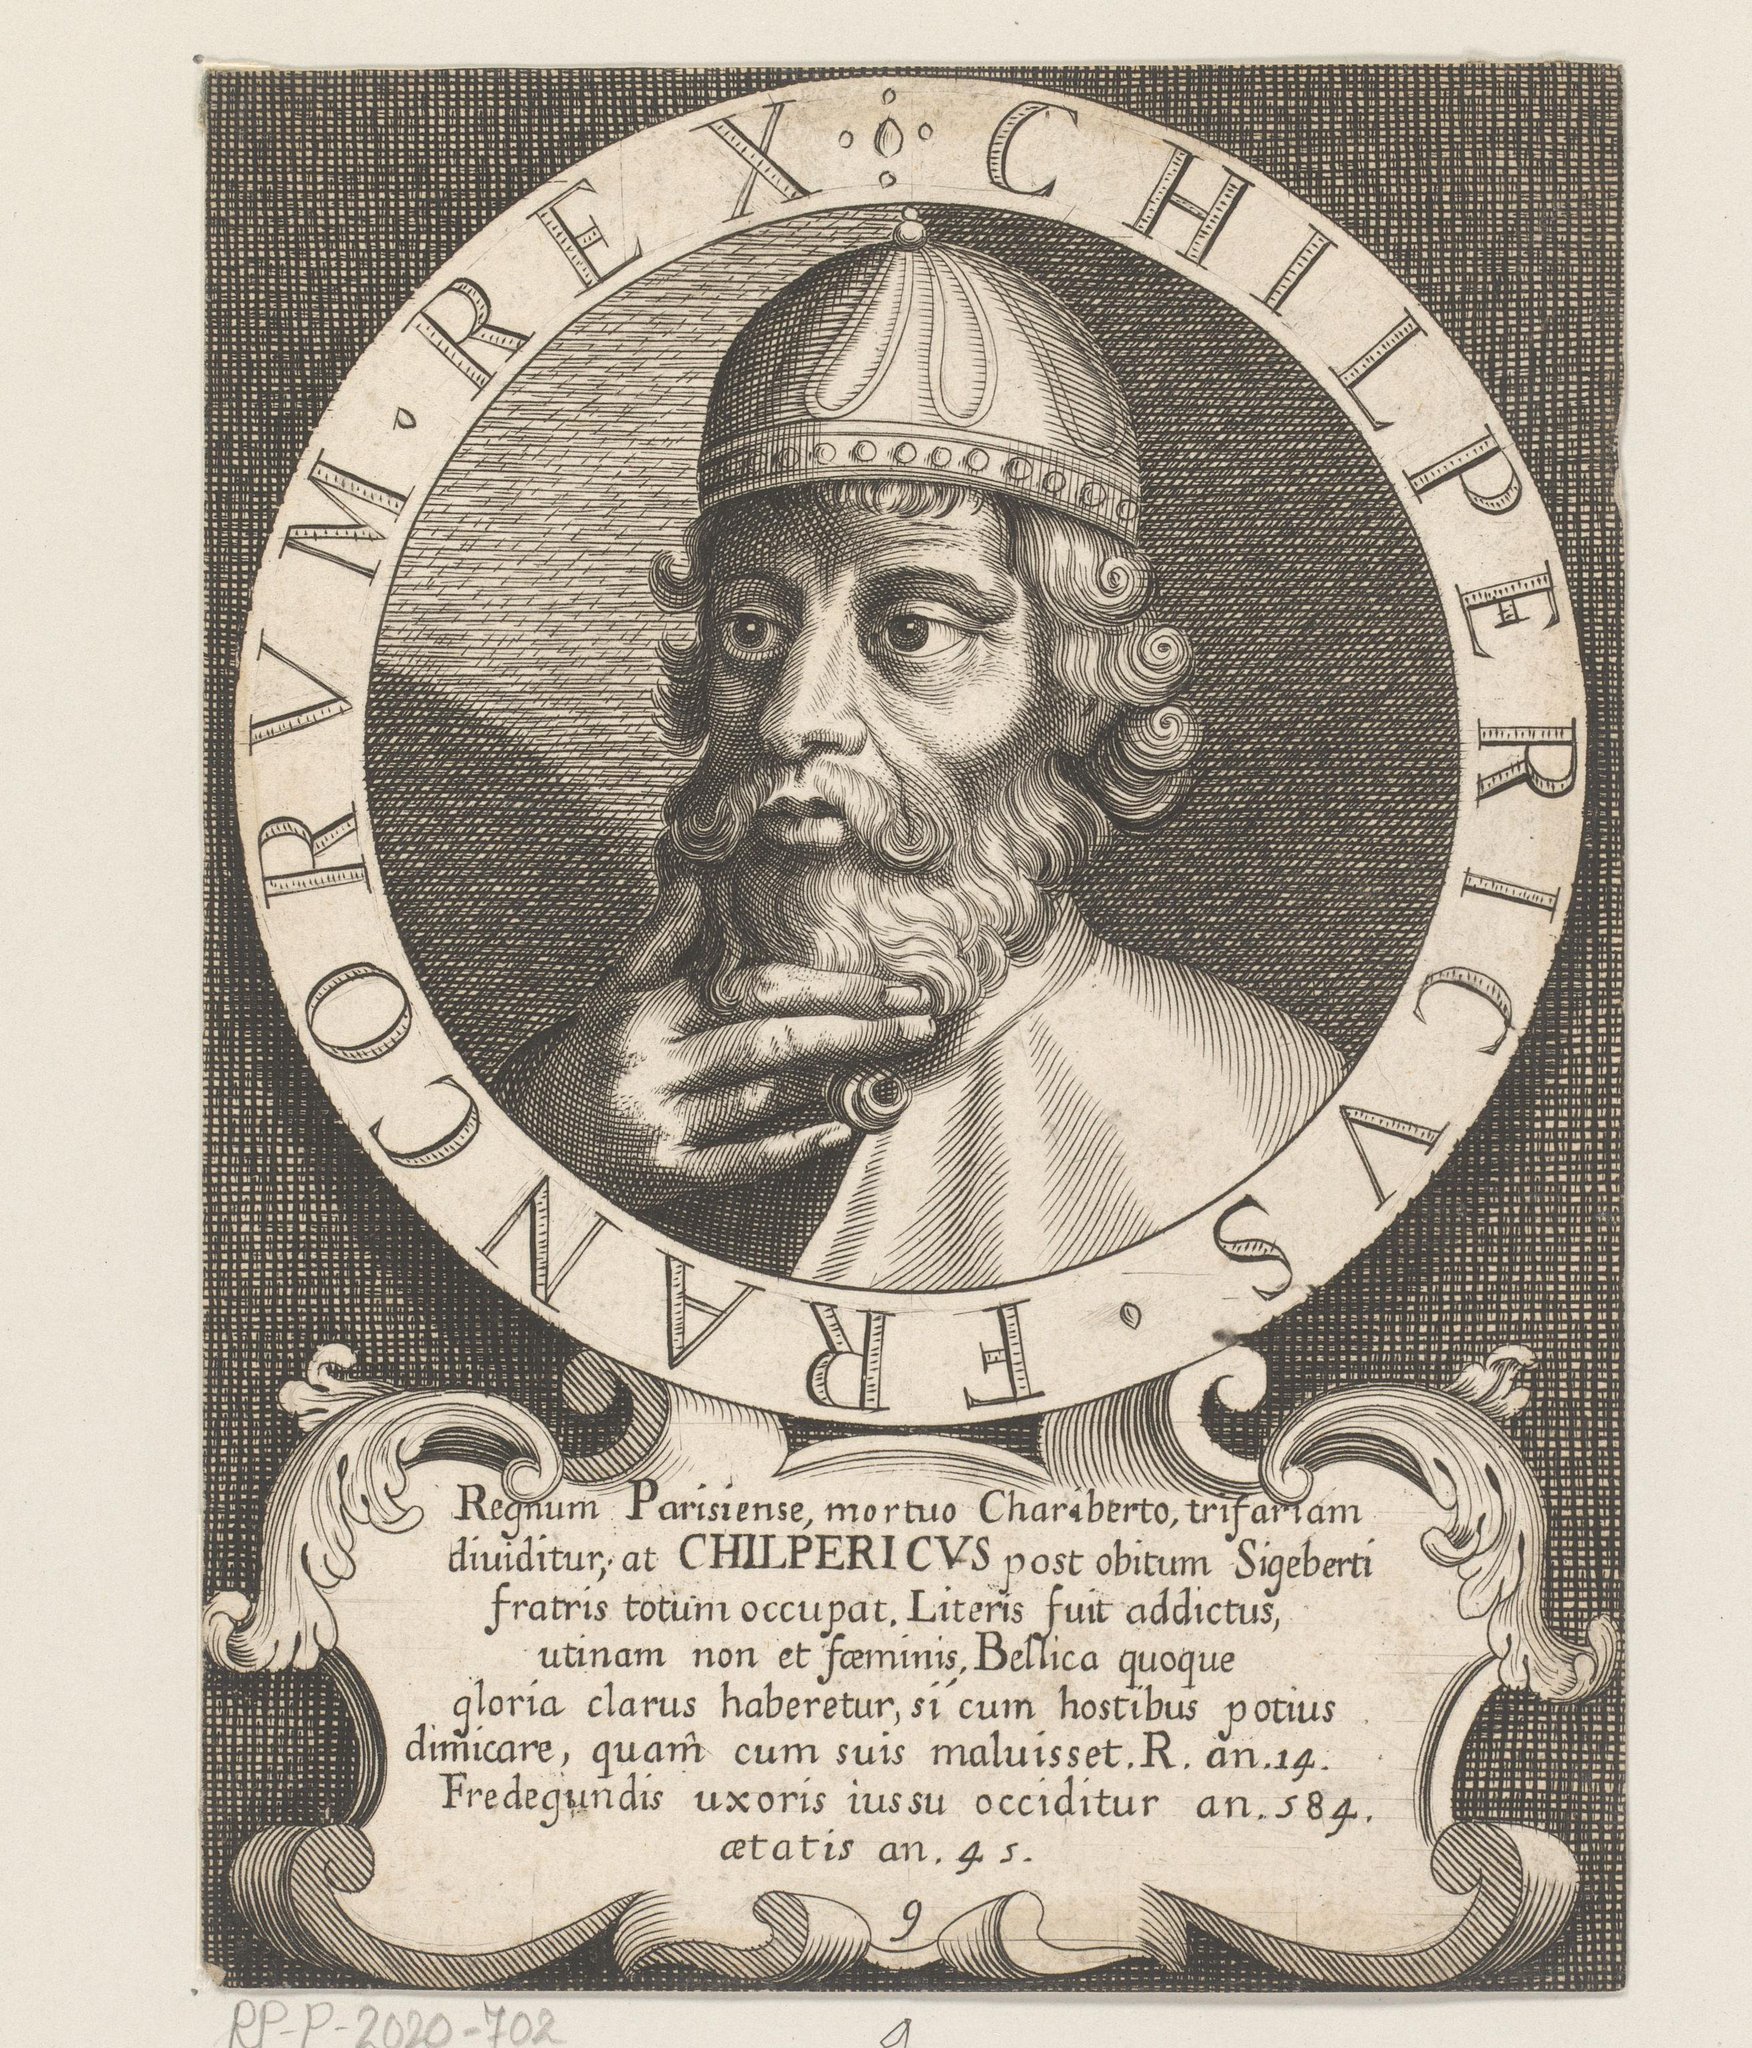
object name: print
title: Chilpericus Francorum Rex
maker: Anonymous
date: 1630-1699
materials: paper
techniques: engraving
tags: historical persons, ruler, sovereign